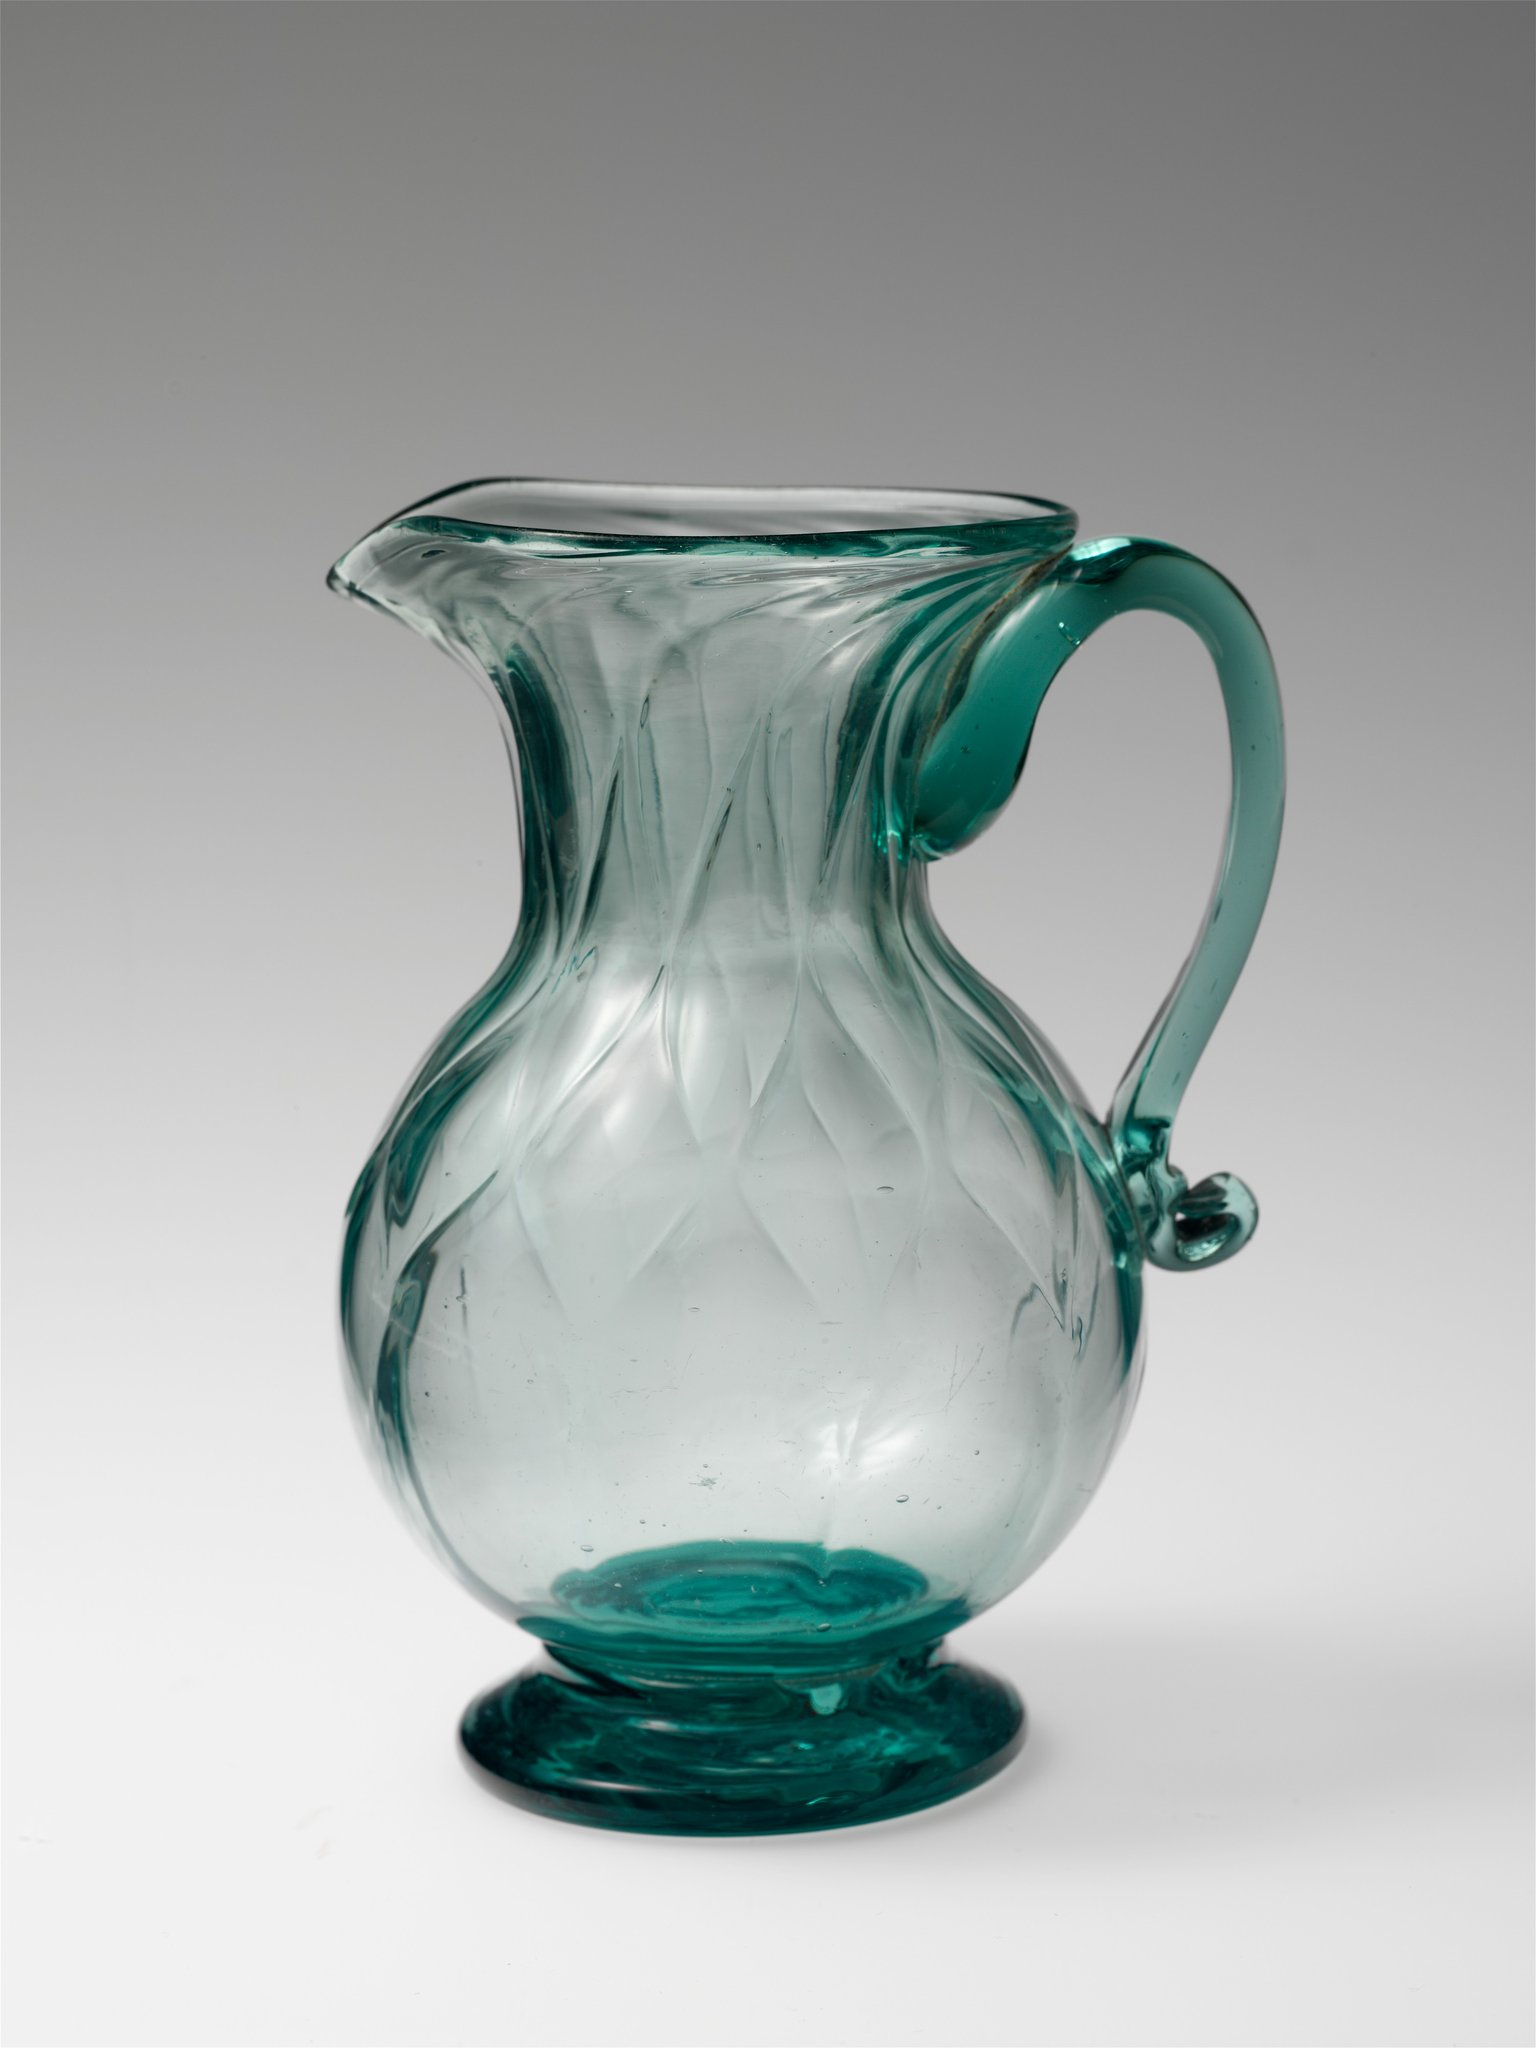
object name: cream pitcher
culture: american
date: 1820-1845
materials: glass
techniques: glassblowing, molding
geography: united states